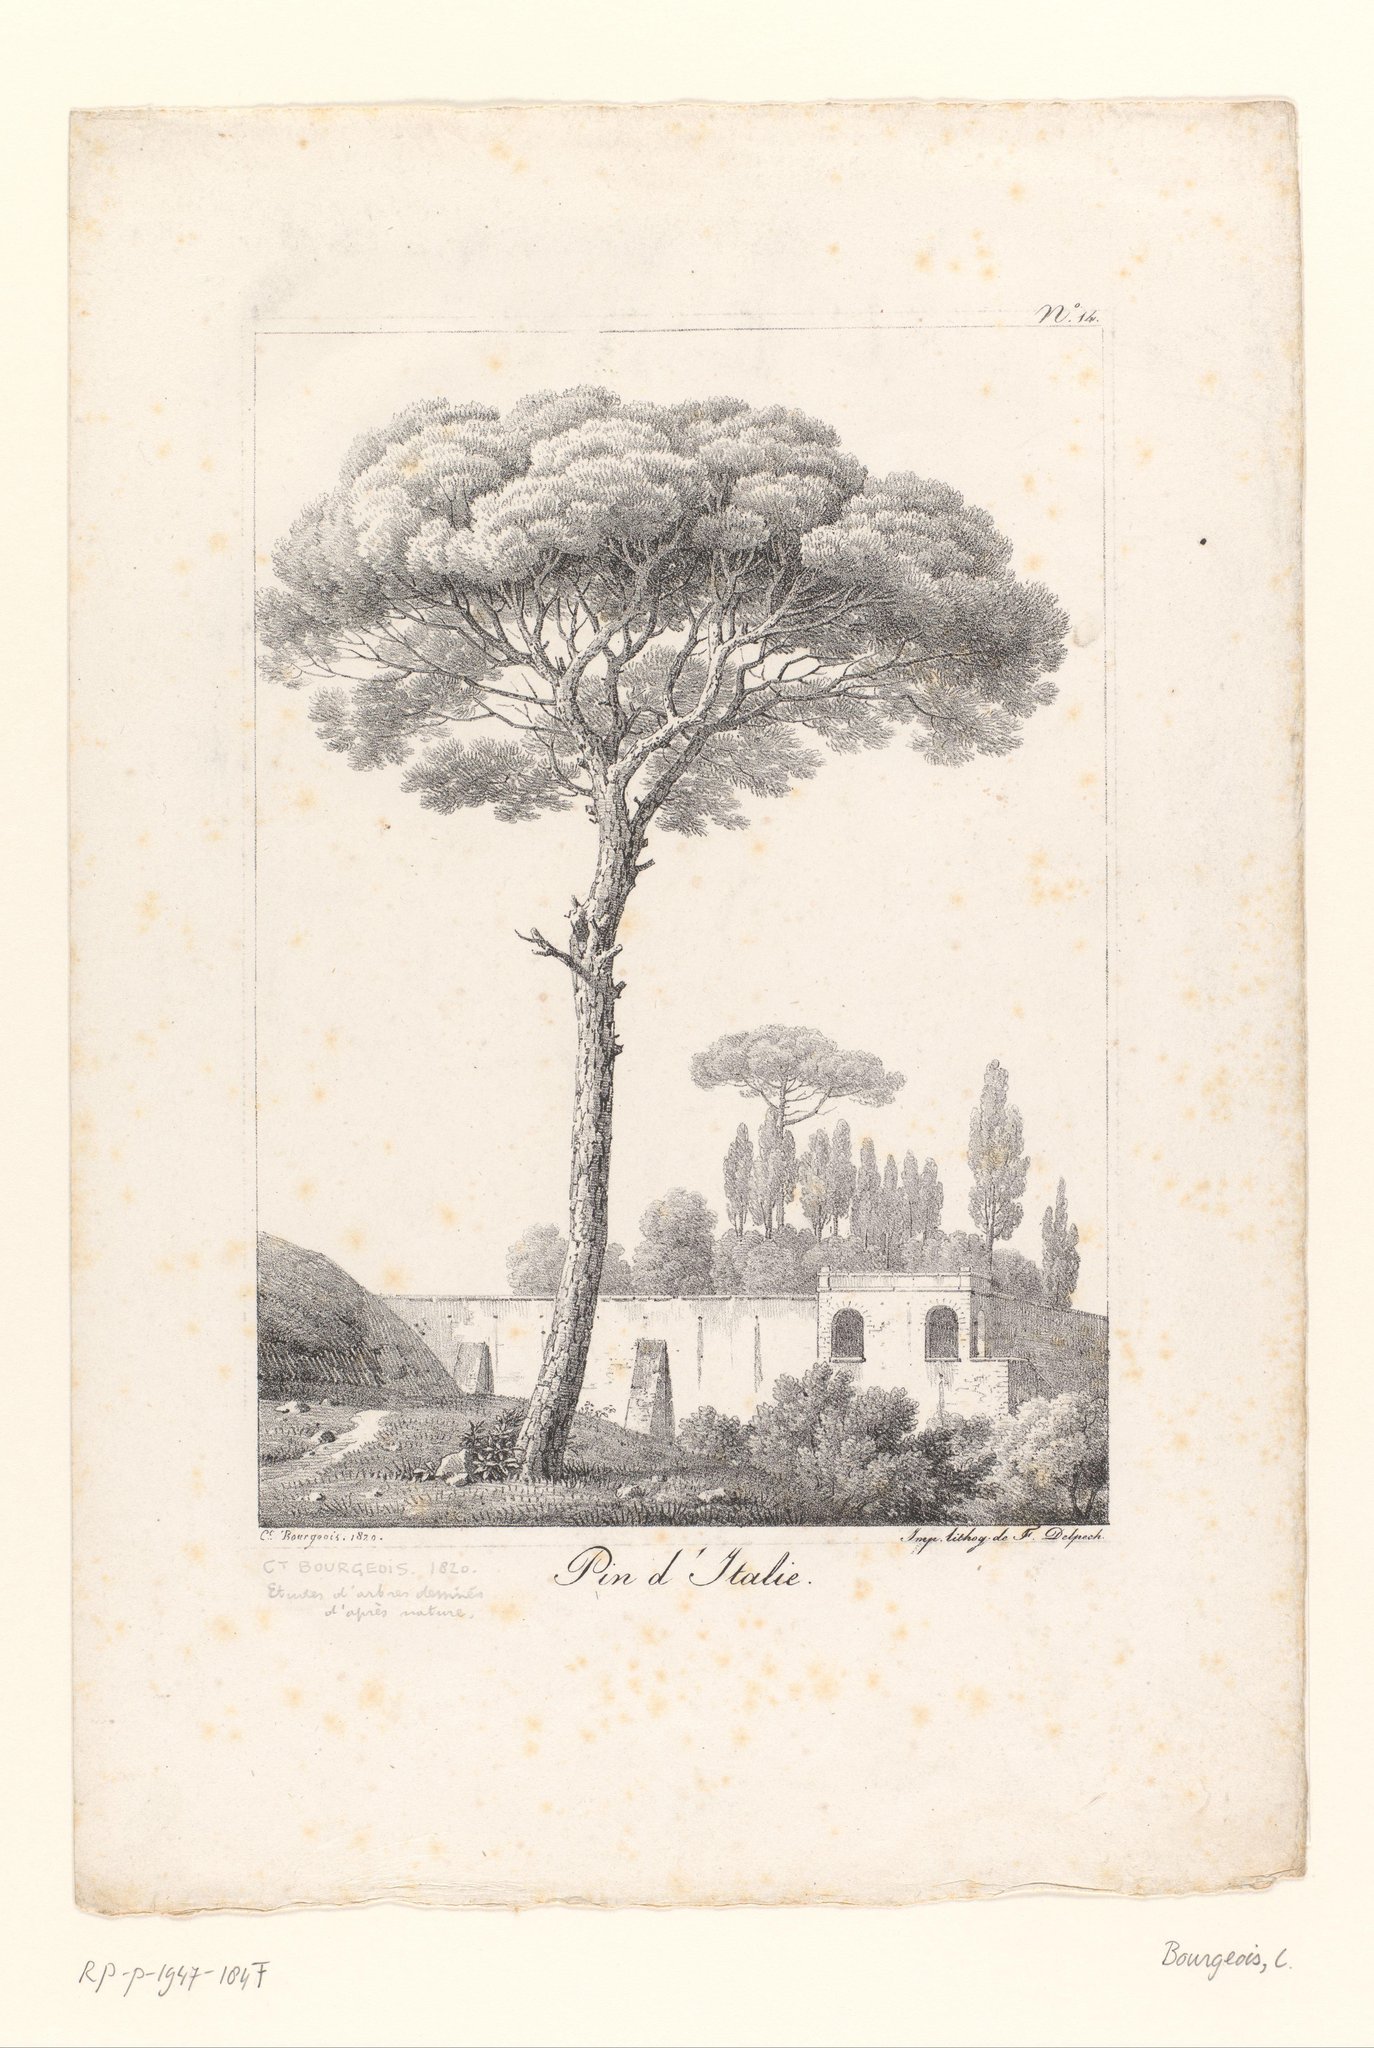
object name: print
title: Parasolden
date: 1820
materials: paper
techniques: lithograph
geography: paris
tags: trees: pine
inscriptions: collector's mark: Lugt 2228a